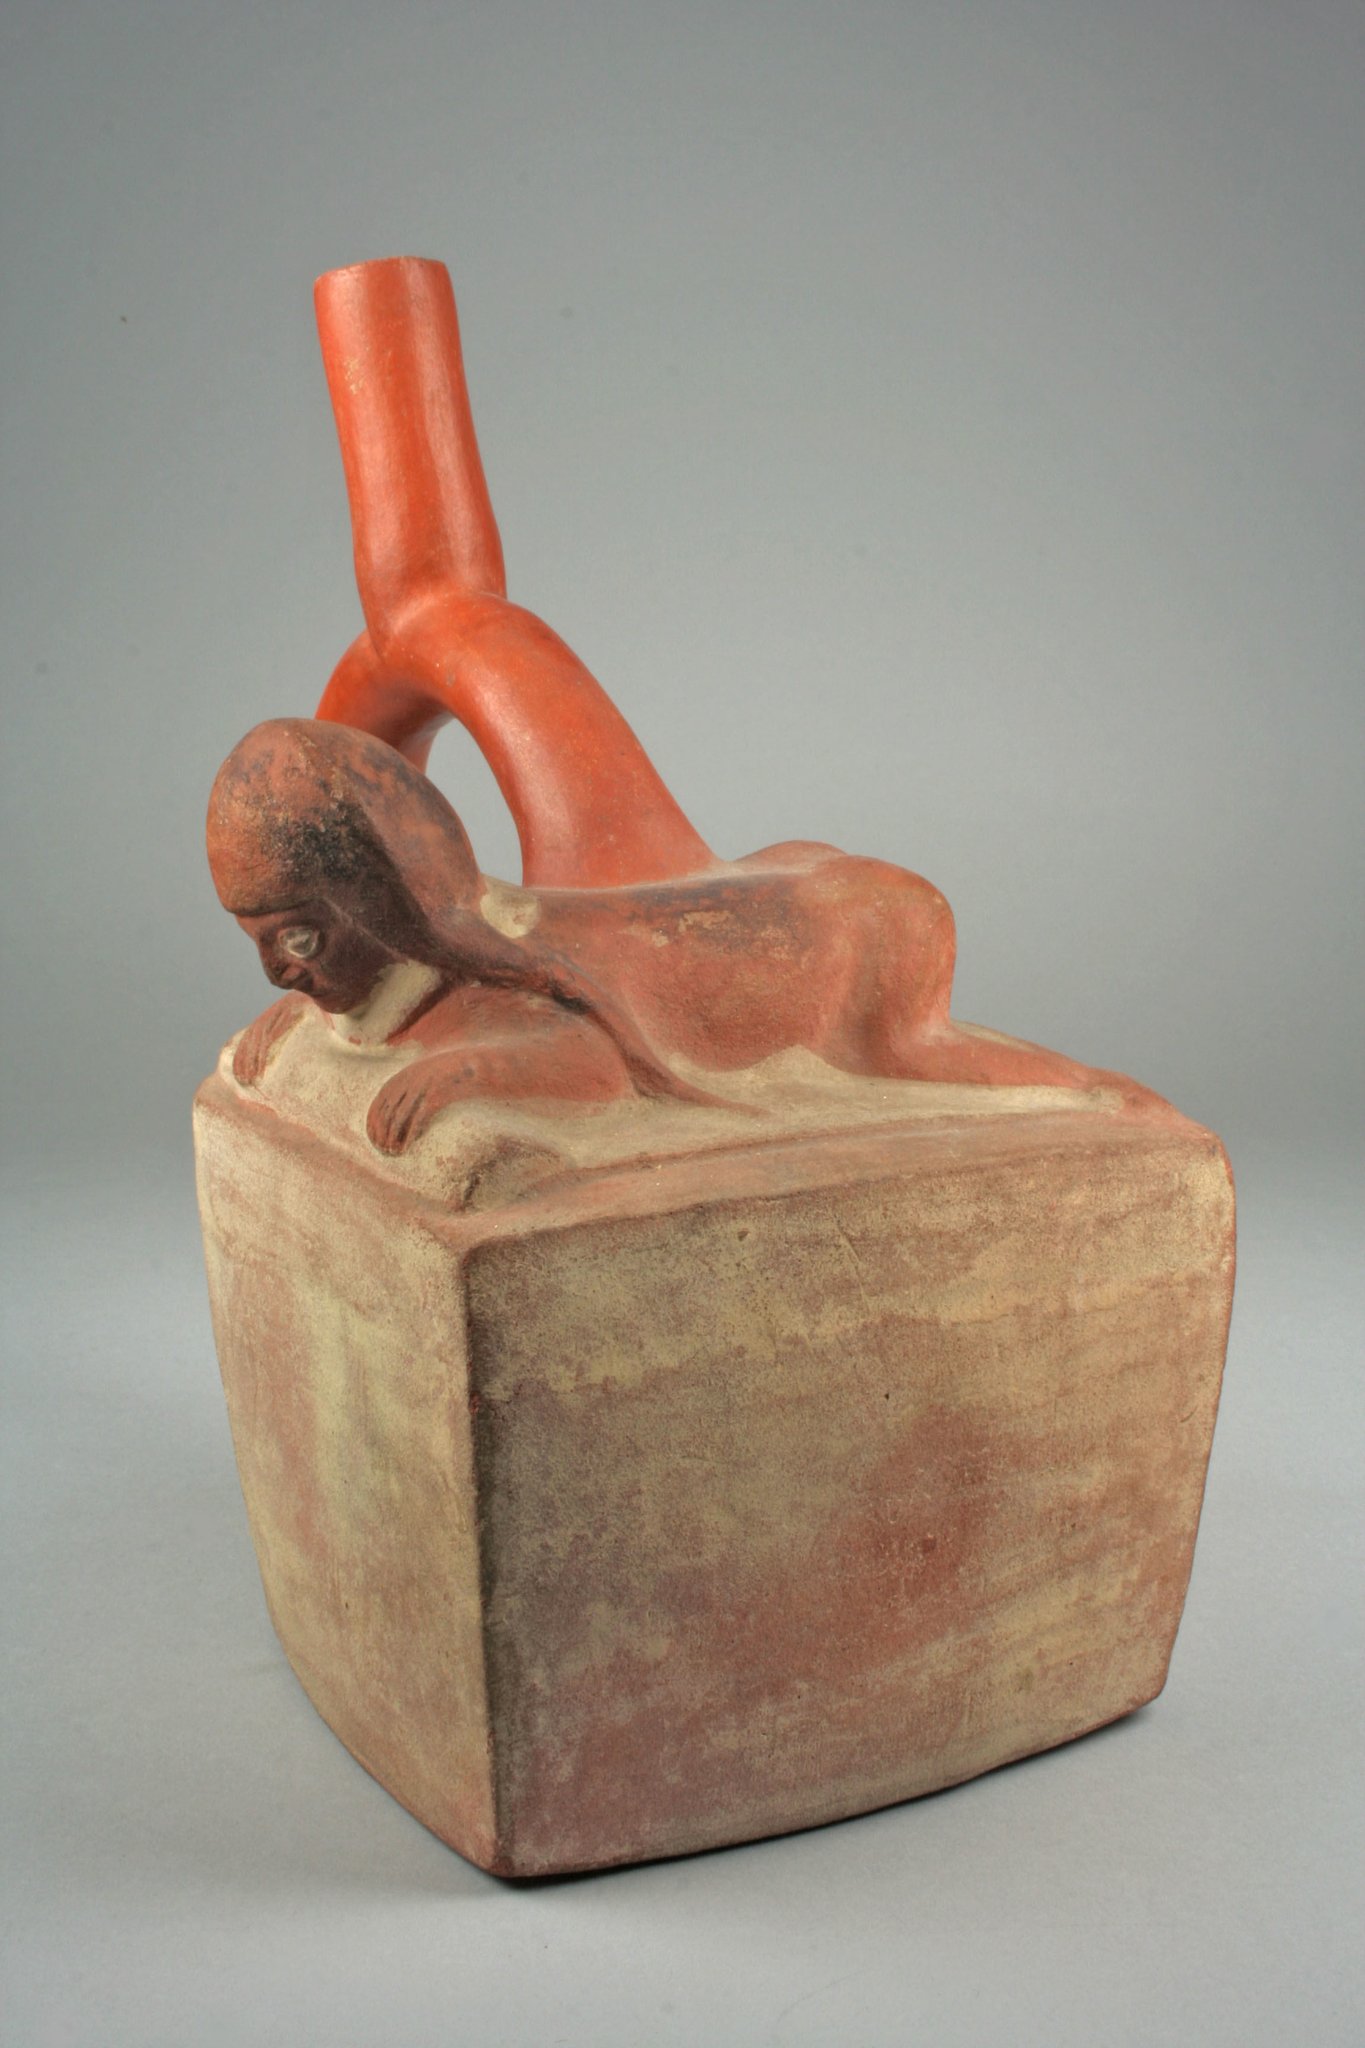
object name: bottle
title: Stirrup Spout Bottle with Female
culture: moche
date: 201-700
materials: ceramic, pigment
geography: peru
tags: women